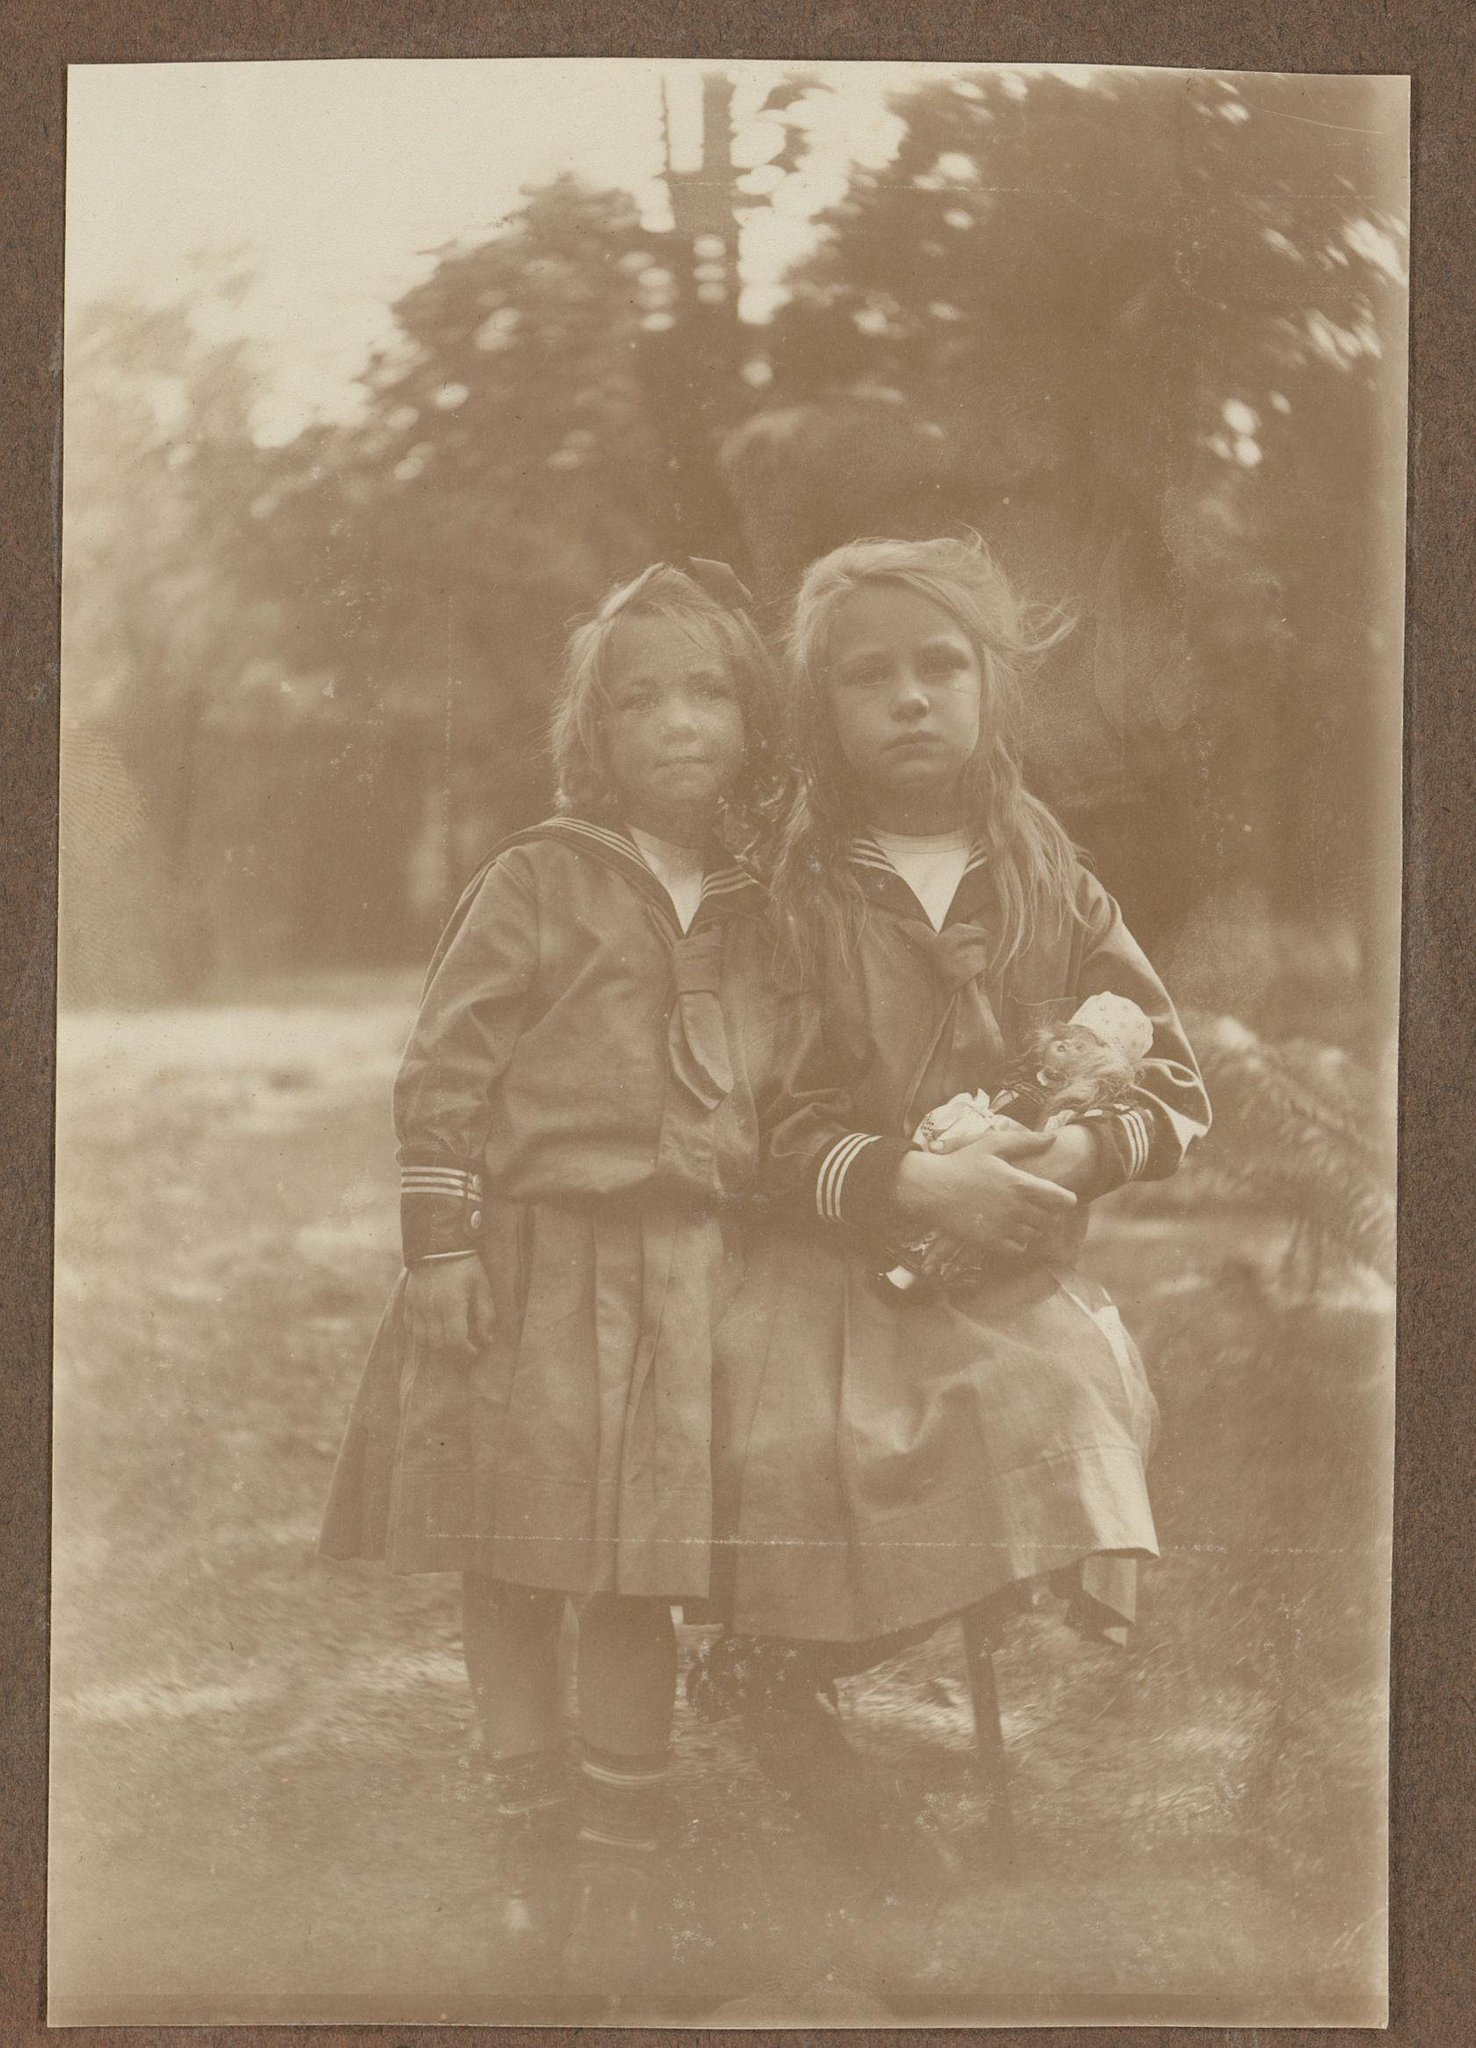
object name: photograph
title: Thea en Joanna Diepenbrock staand in veld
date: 1912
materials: photographic support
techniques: photography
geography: netherlands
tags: laren, zanger, joanna diepenbrock, thea diepenbrock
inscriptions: date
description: Foto op bruin albumblad 7 van familiealbum van Alphons Diepenbrock.